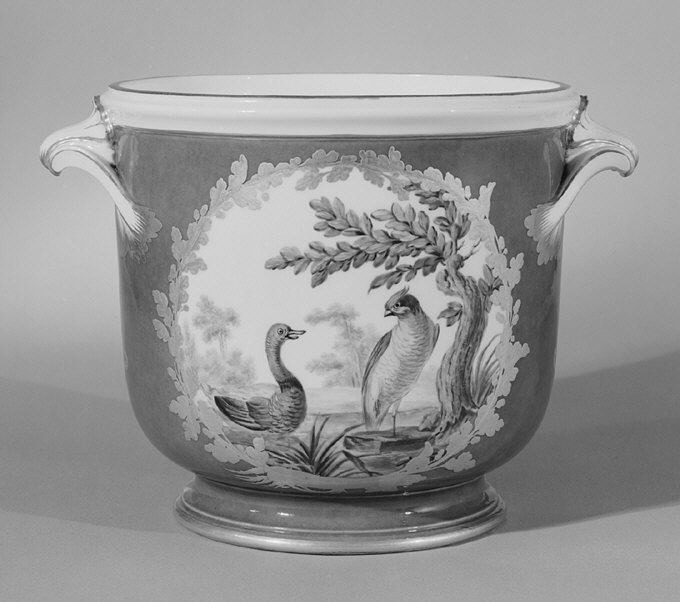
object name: cooler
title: Wine-bottle cooler (seau à bouteille) (part of a service)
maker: sèvres manufactory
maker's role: manufactory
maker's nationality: french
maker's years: 1740-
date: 1771-1772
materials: soft paste porcelain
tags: birds,trees